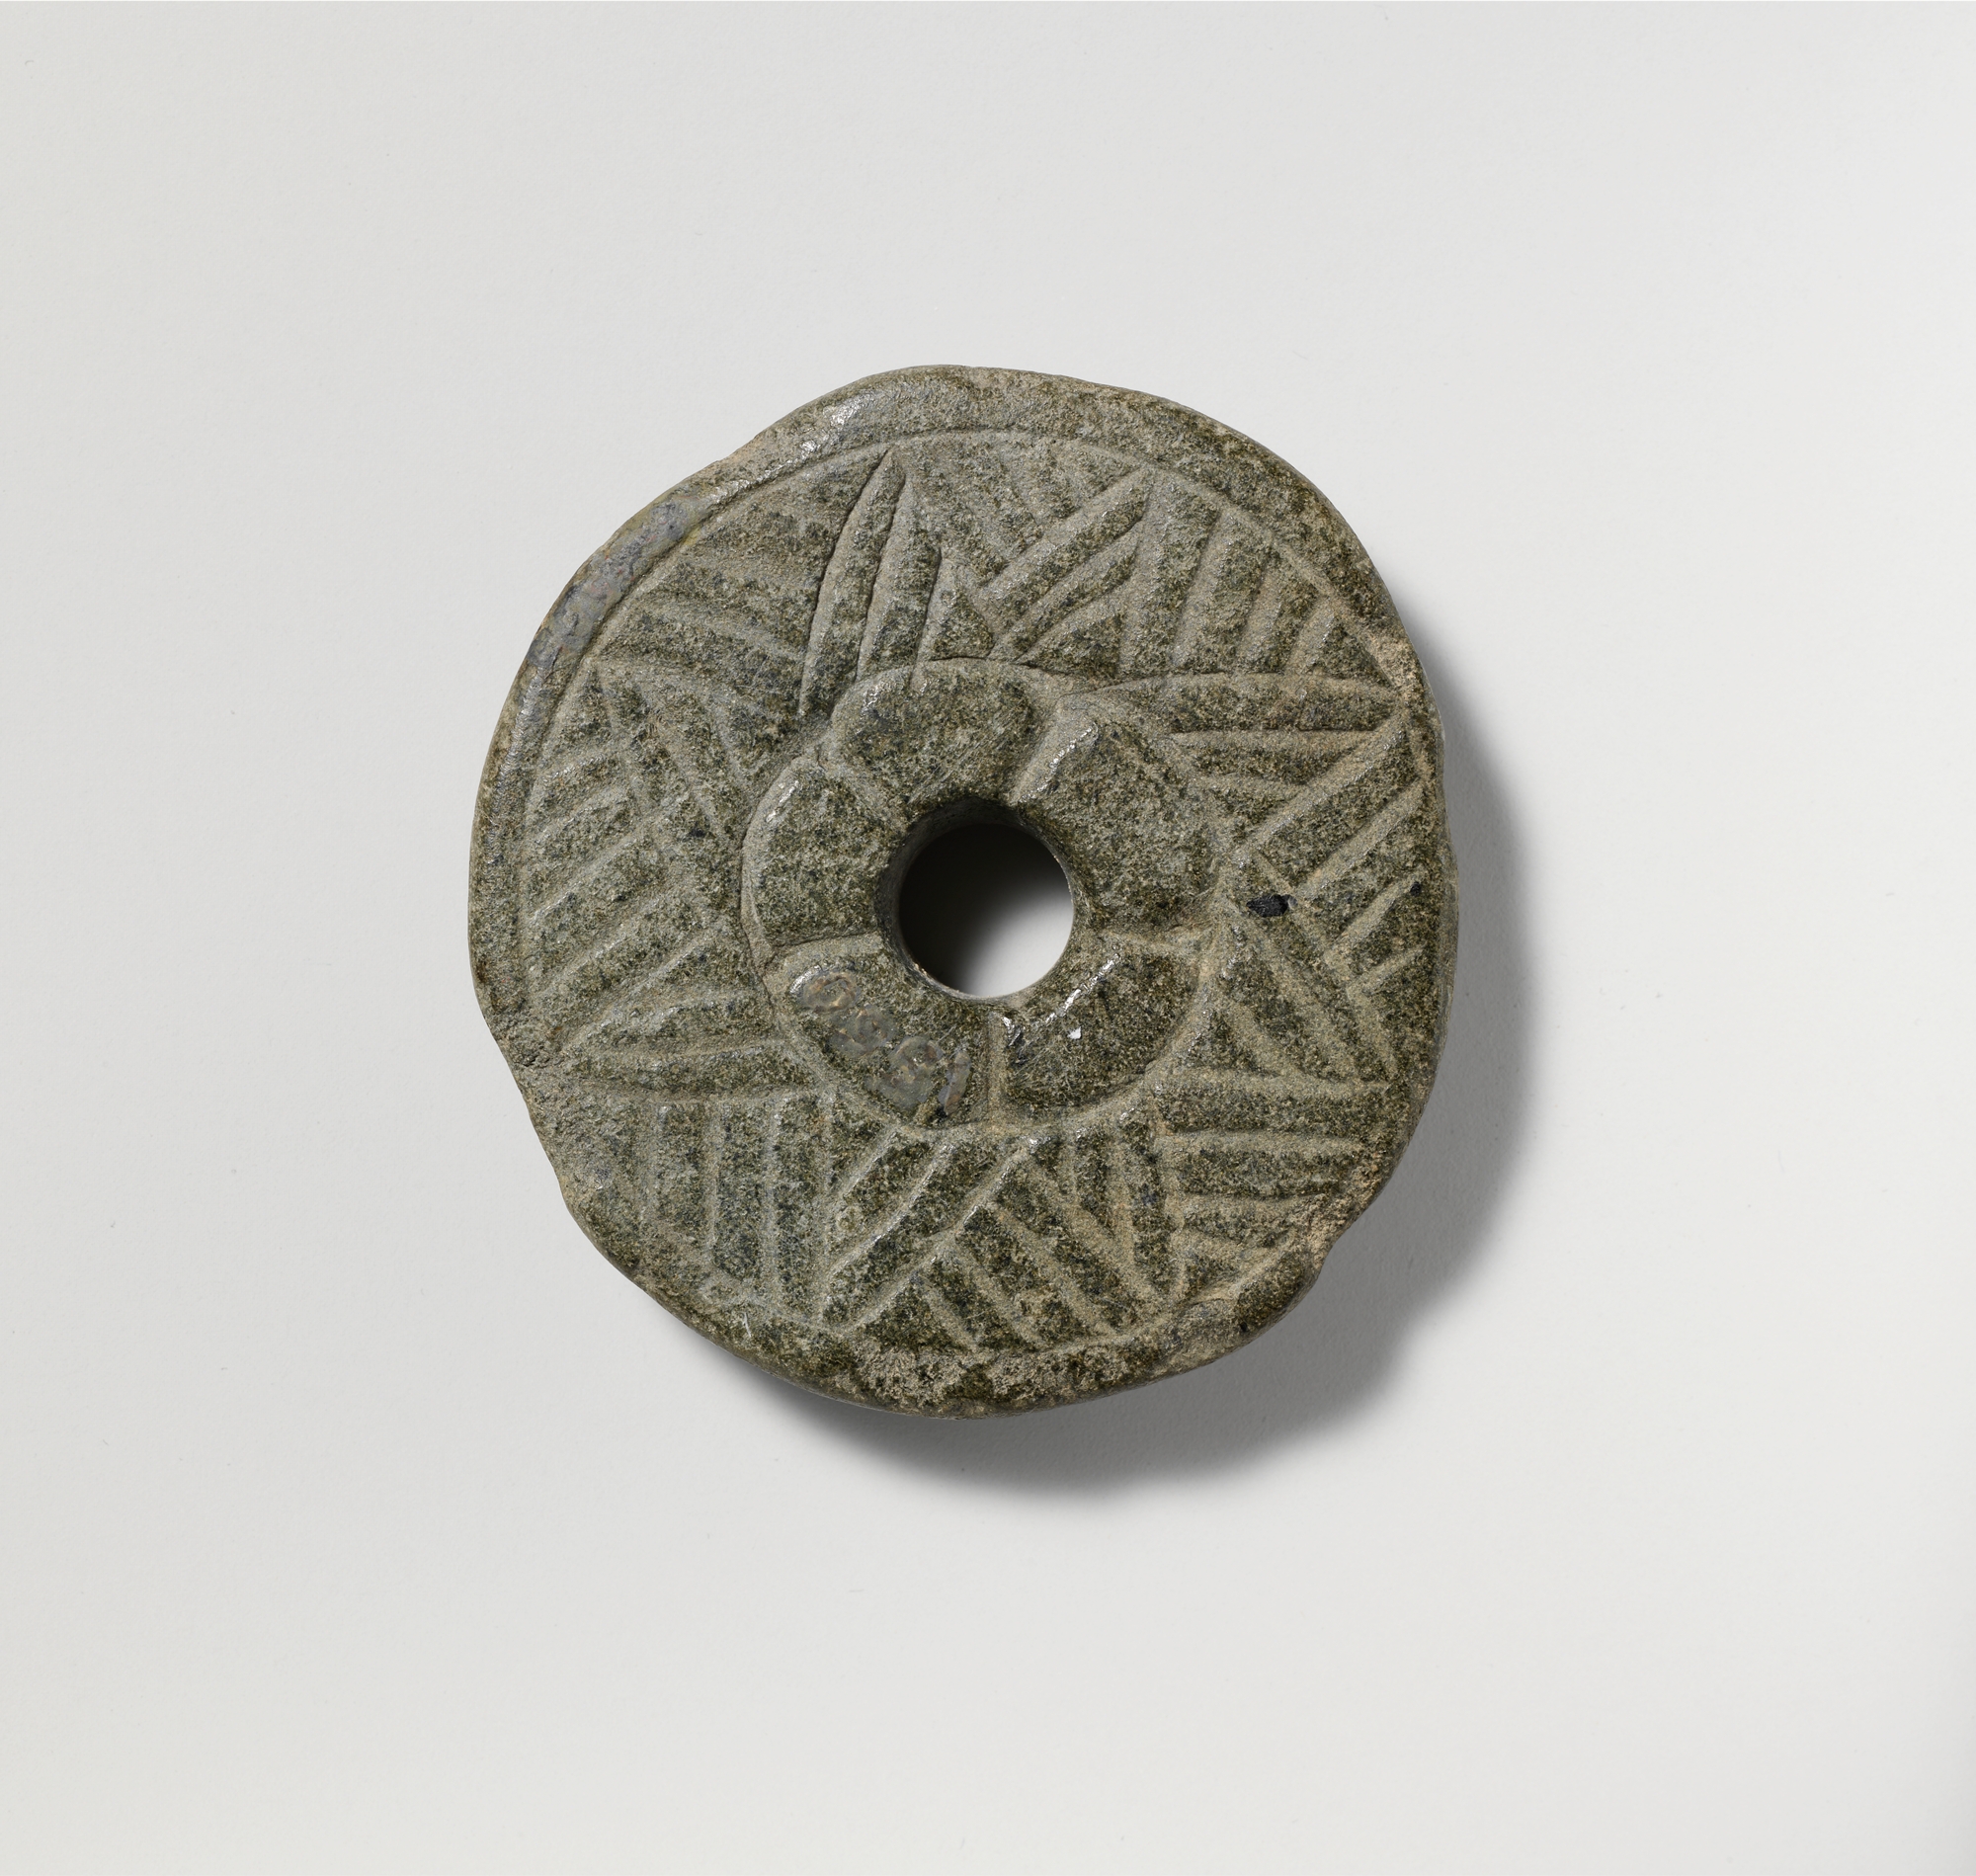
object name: box with lid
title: Chlorite box lid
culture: cypriot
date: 1200-1050 BCE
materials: mineral